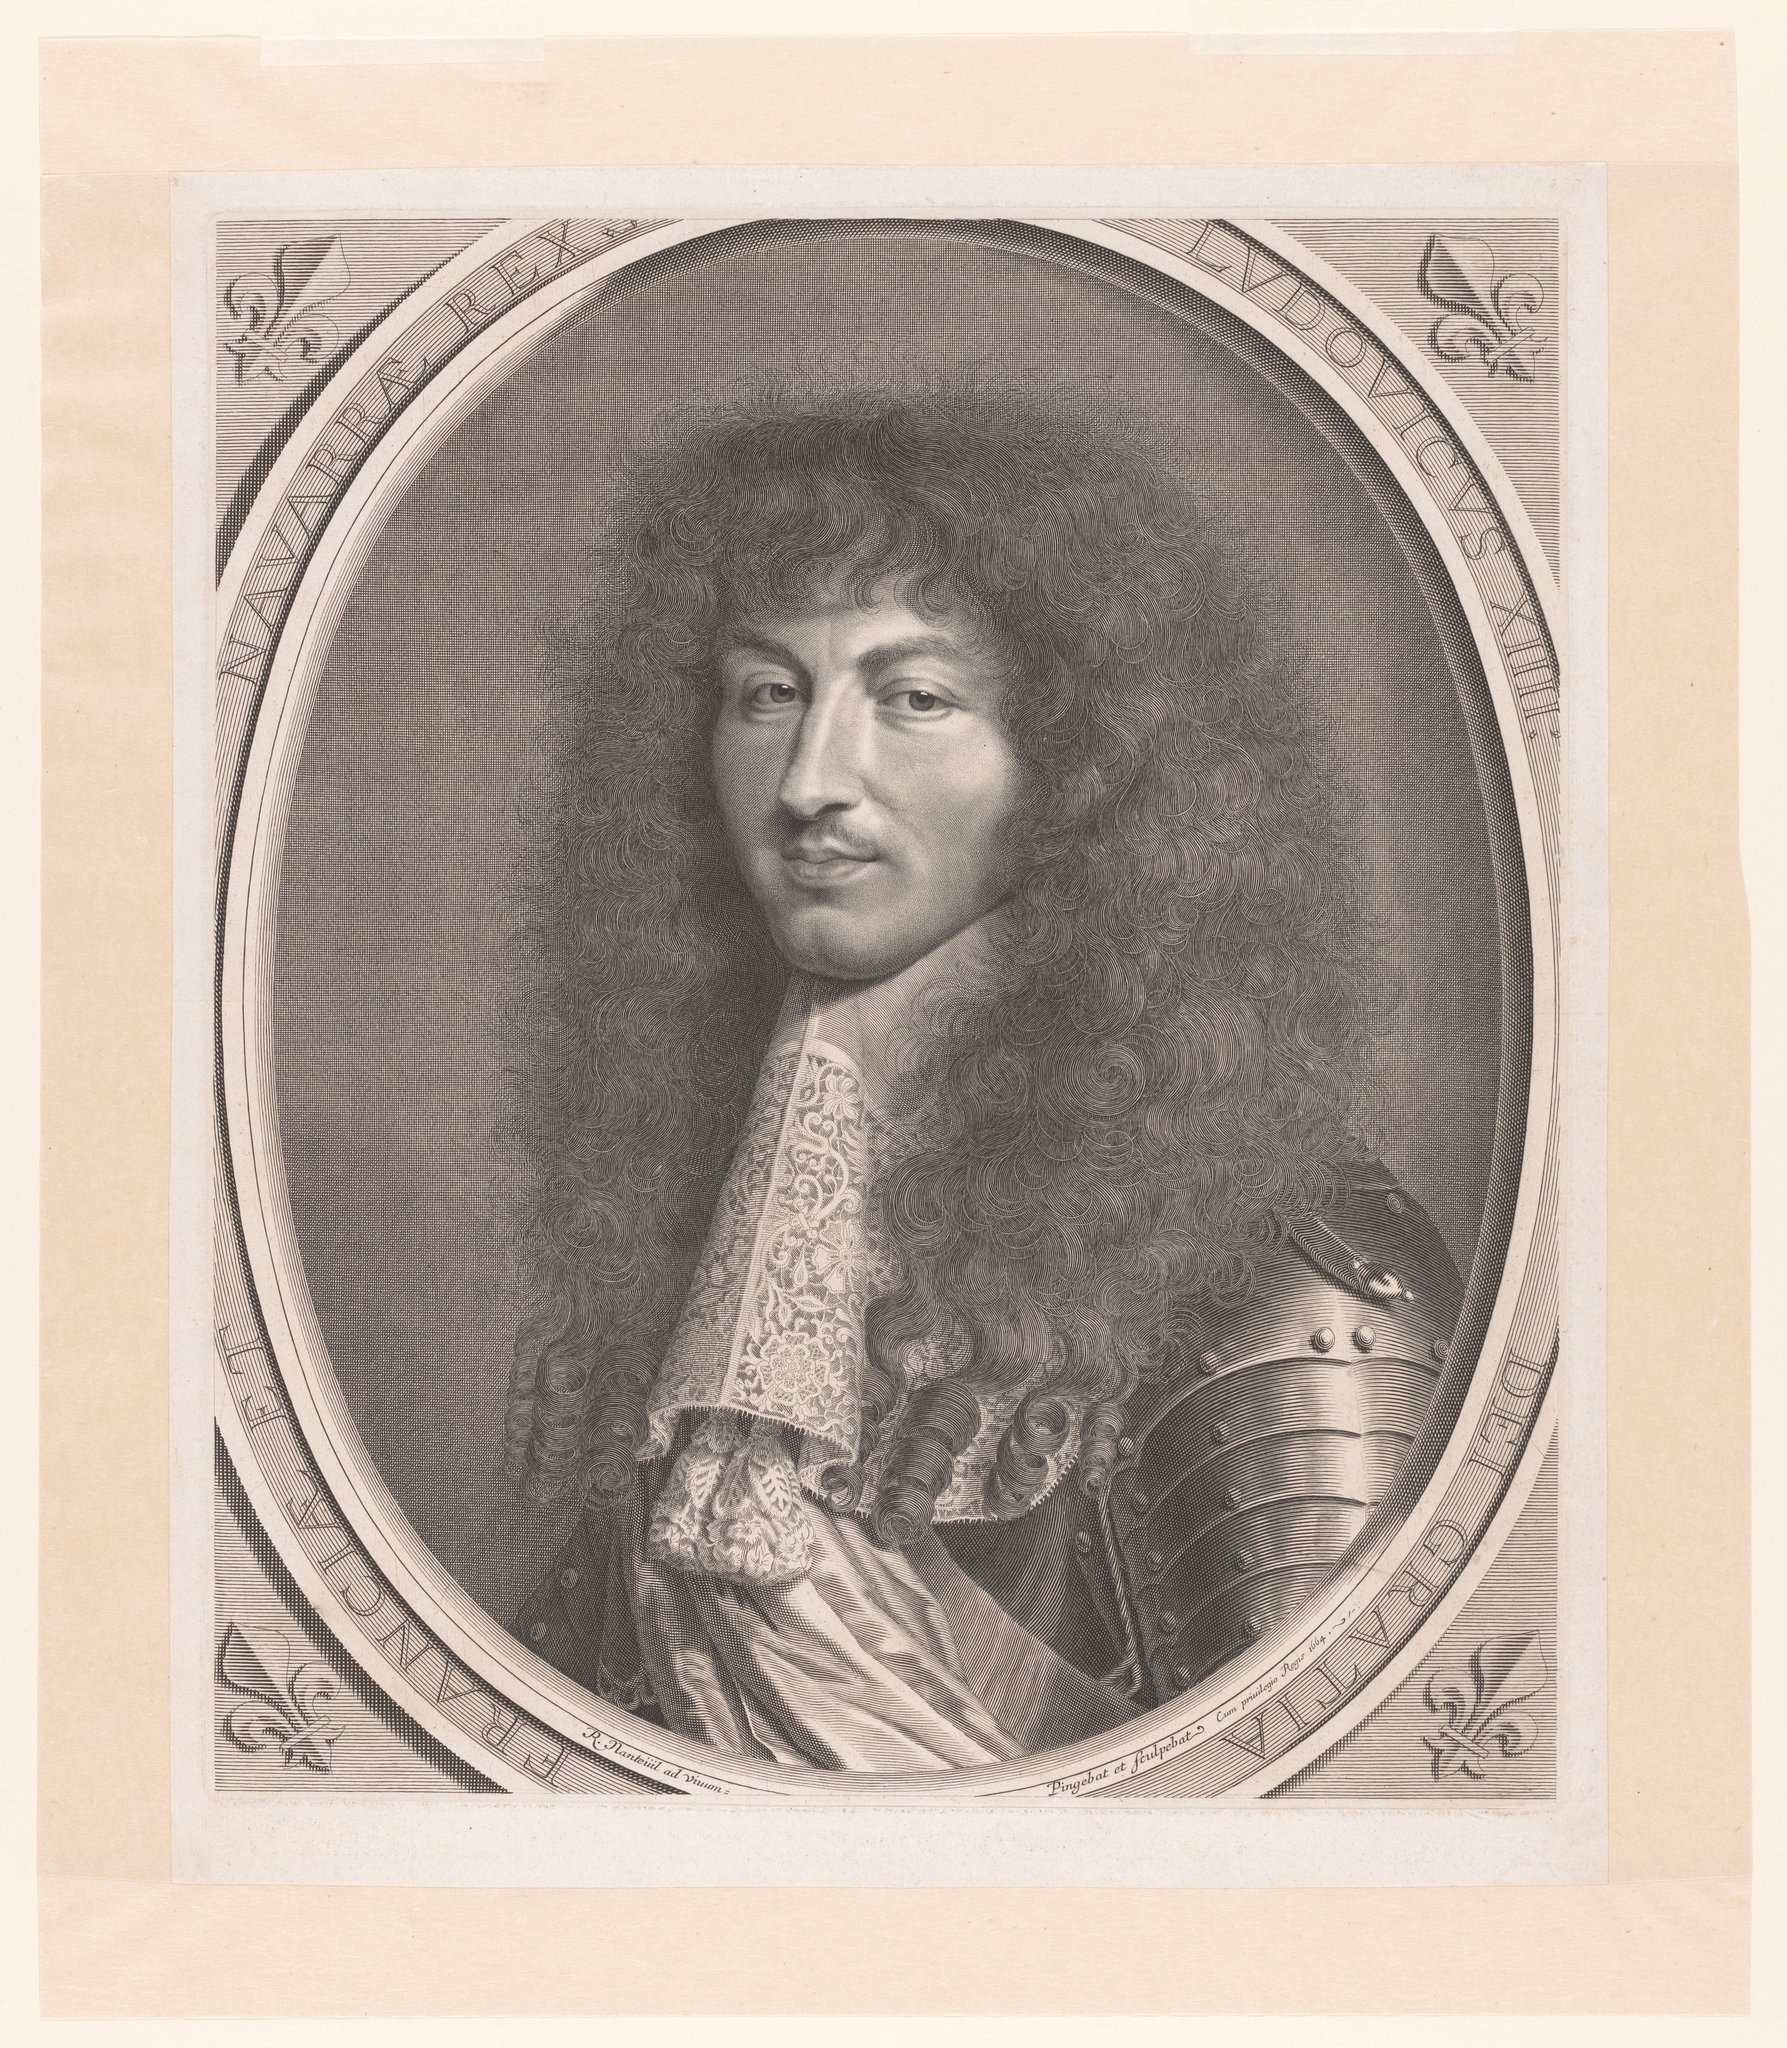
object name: print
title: Portret van Lodewijk XIV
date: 1664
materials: paper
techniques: engraving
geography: france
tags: lodewijk xiv (koning van frankrijk), fleur-de-lis ~ ornament, historical persons, king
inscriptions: collector's mark: Lugt 2228